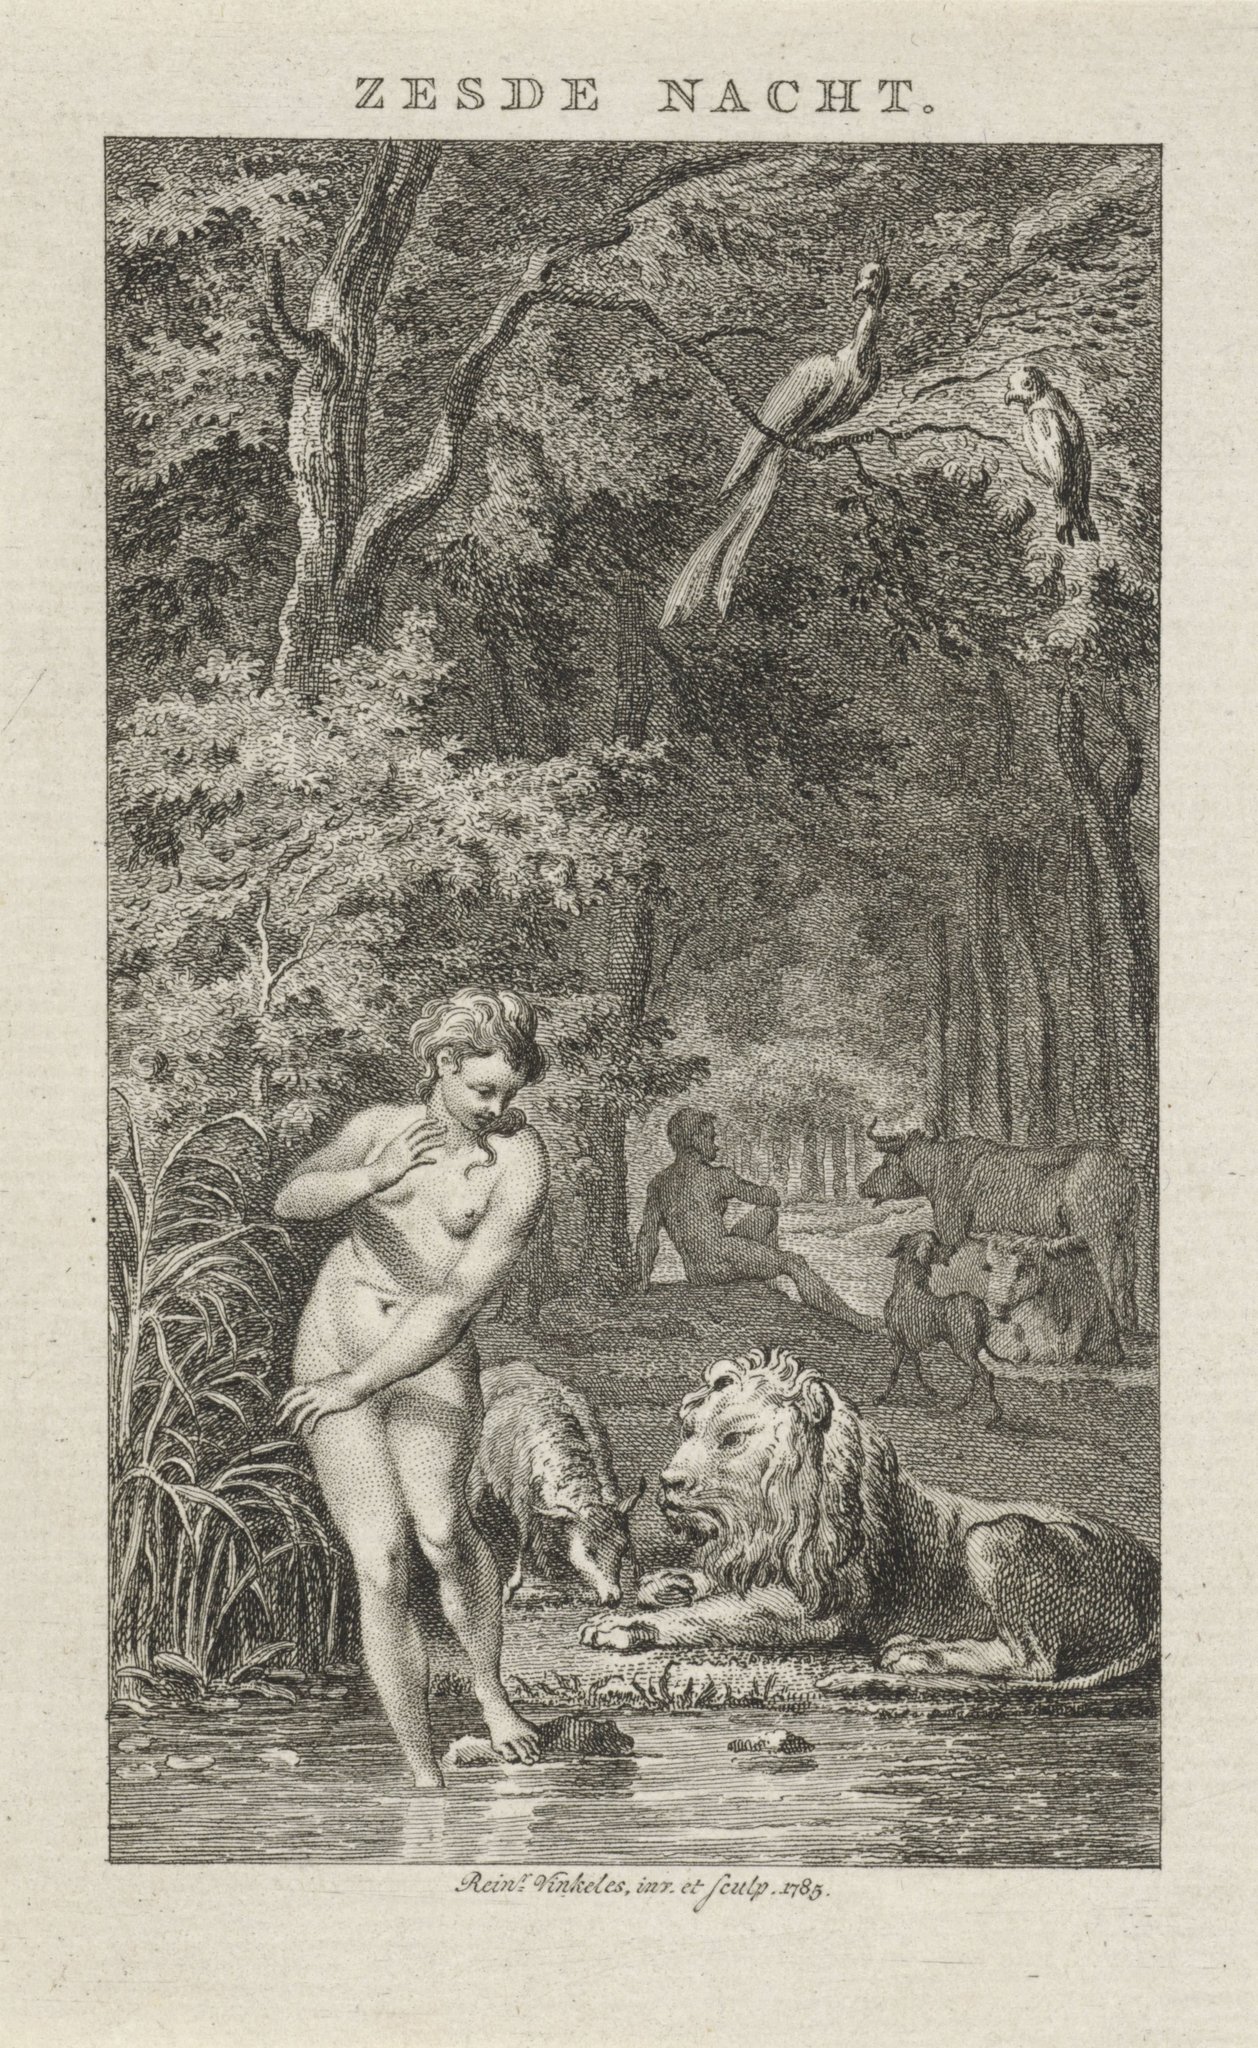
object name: print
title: Zesde Nacht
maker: reinier vinkeles (i)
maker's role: draughtsman, print maker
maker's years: 1741-1816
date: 1785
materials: paper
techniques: engraving, etching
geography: amsterdam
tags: lake, forest, wood, taking a bath - aa - in the open air, night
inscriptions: collector's mark: Lugt 2228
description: Een jonge vrouw staat tot haar enkels in een meertje en lijkt een bad te gaan nemen. Aan de waterkant liggen een leeuw en een lam. Op de achtergrond een man, een hond en twee runderen.